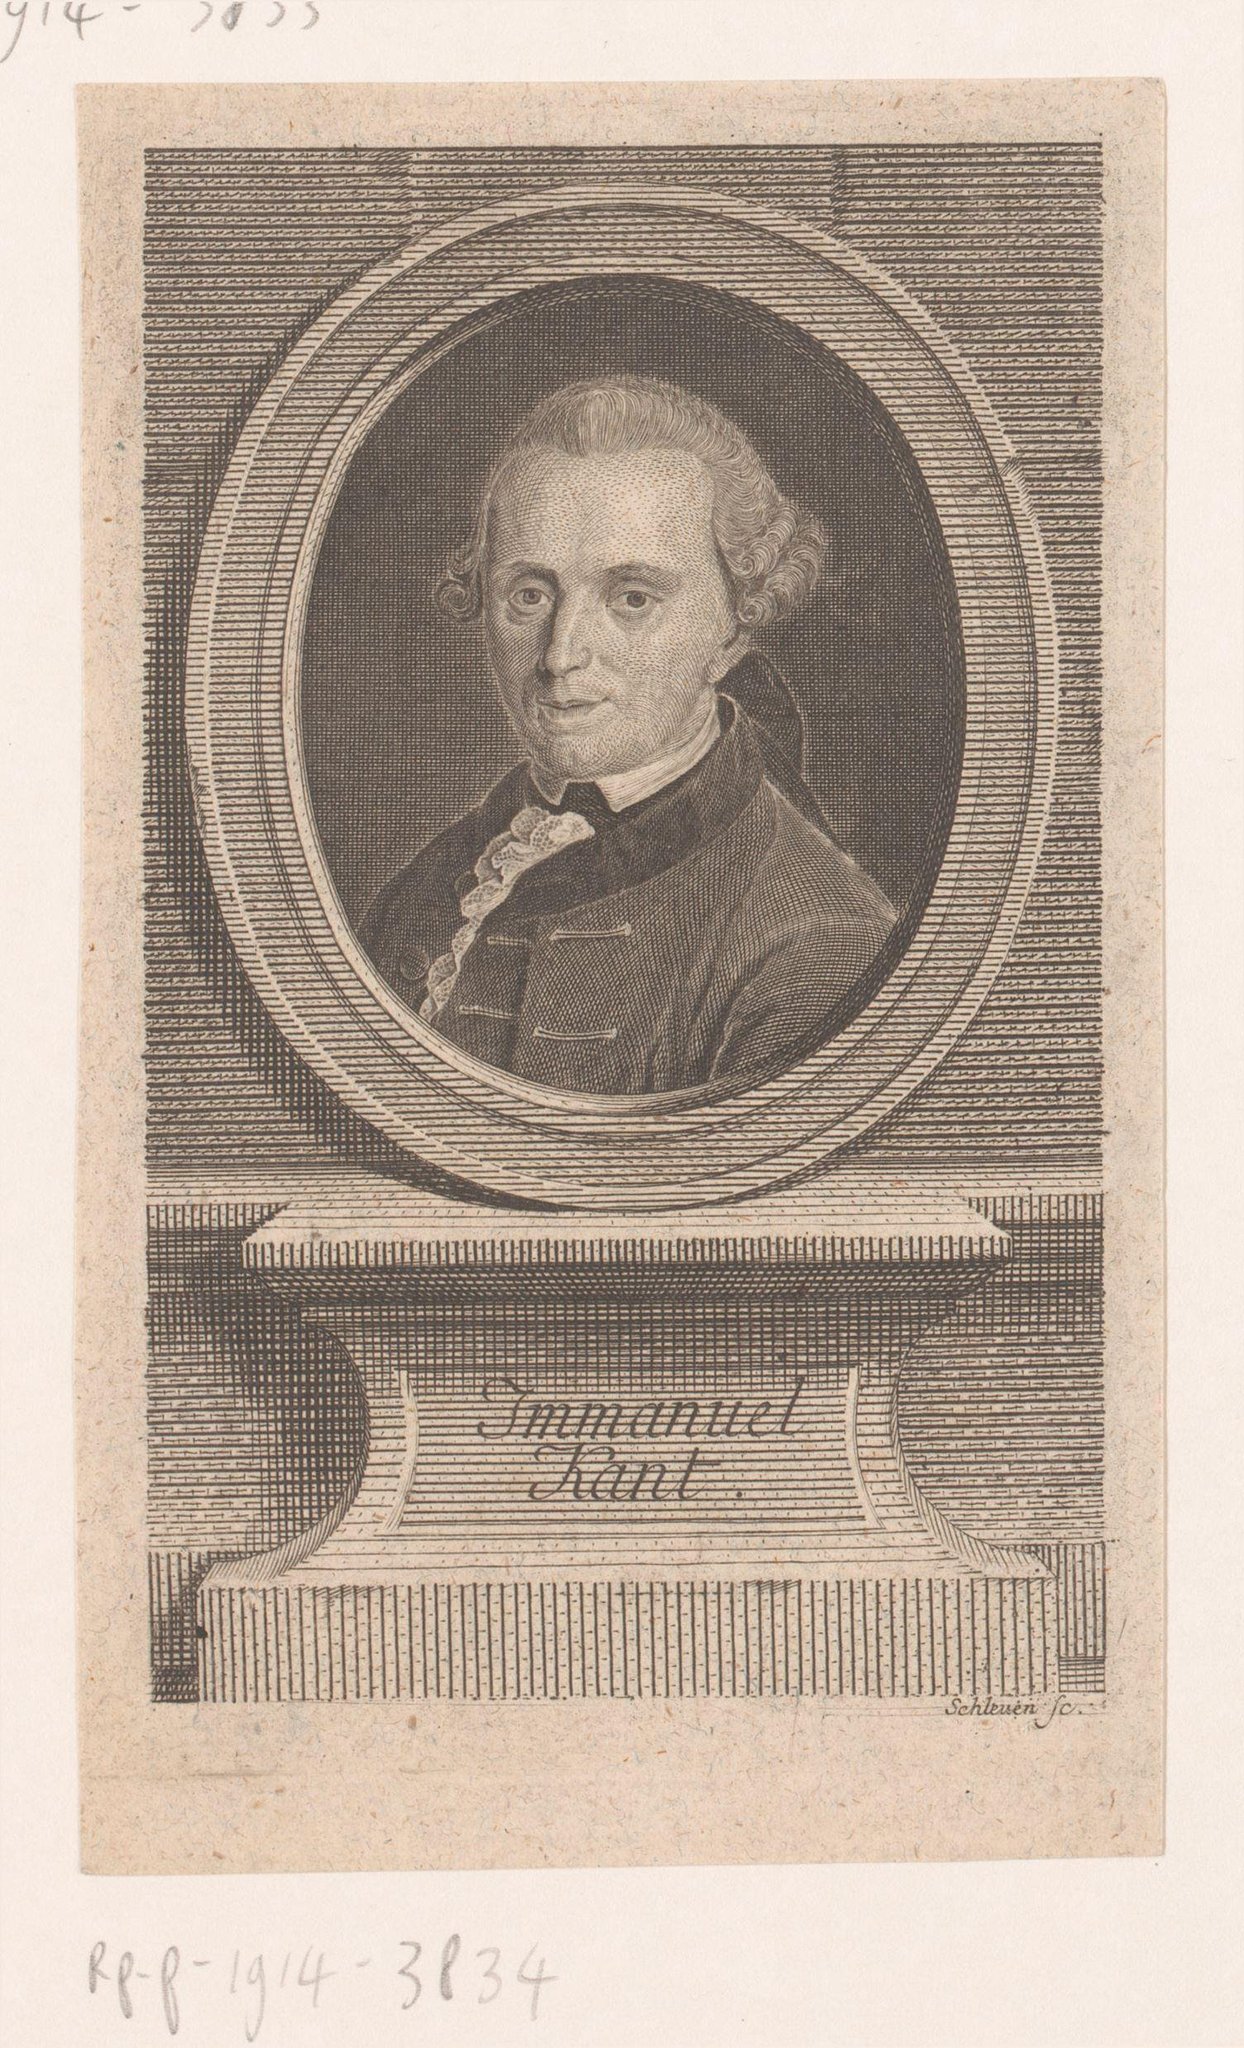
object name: print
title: Portret van Immanuel Kant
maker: johann david schleuen (i)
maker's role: print maker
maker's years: 1711-1774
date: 1721-1771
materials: paper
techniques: engraving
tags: scholar, philosopher, historical persons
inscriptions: collector's mark: Lugt 2228